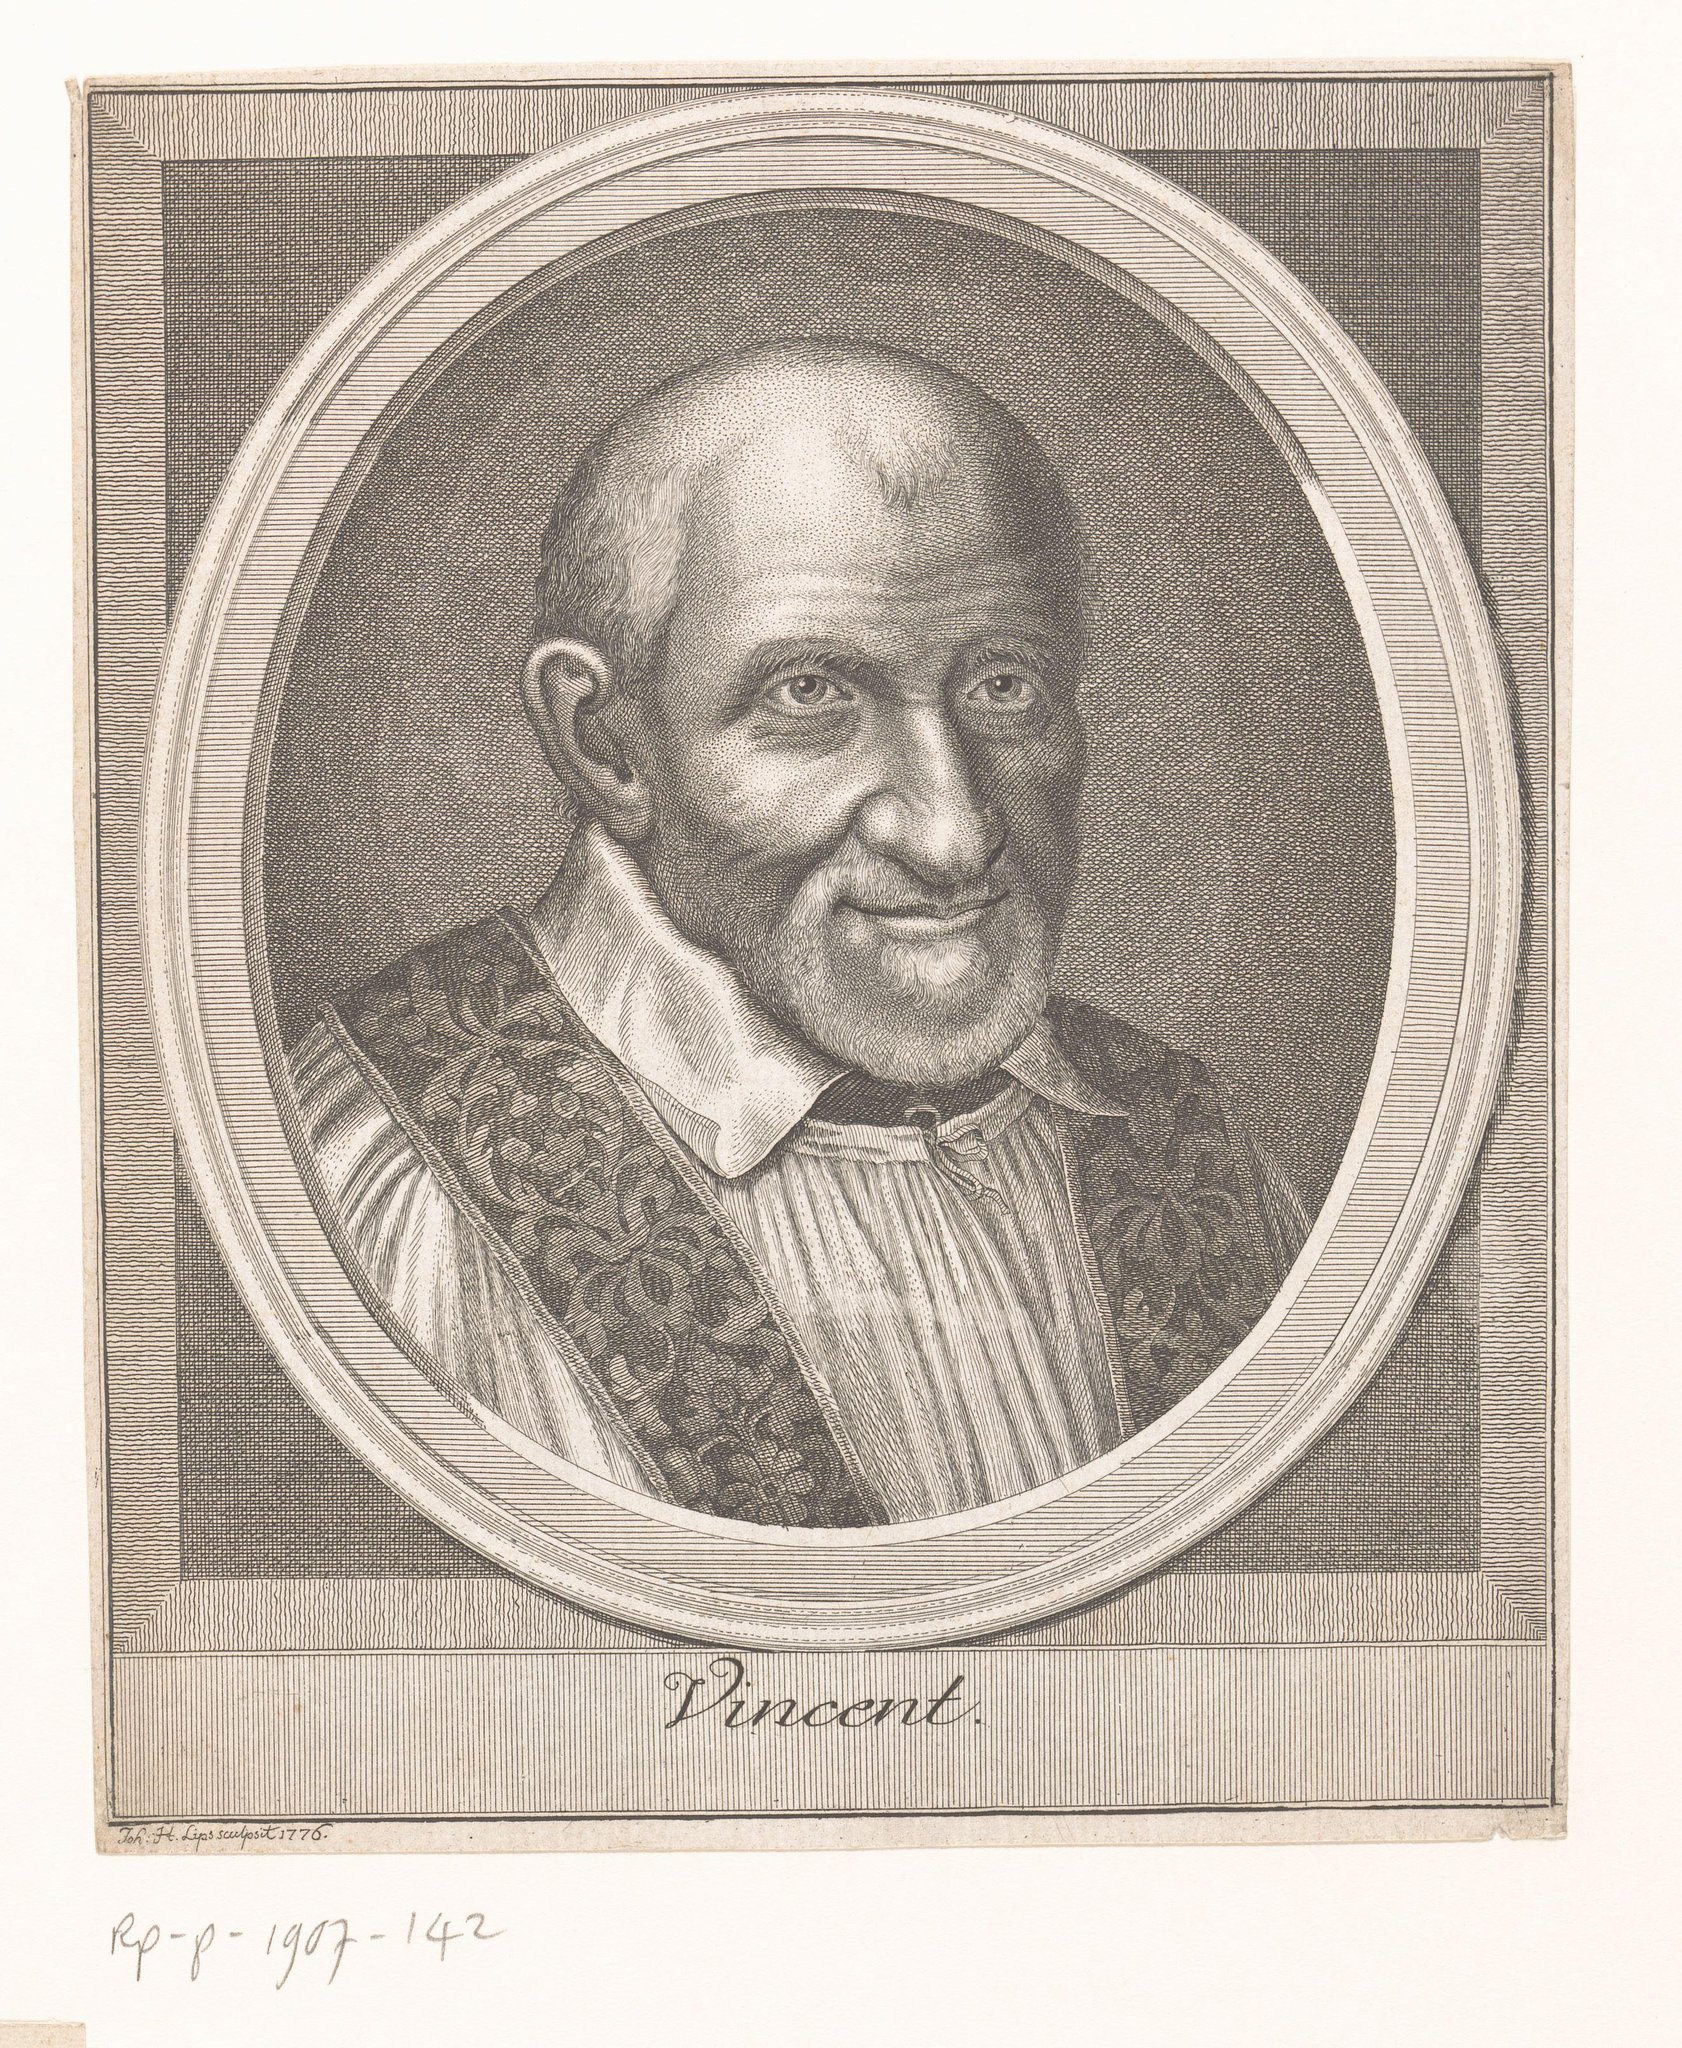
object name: print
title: Portret van Vincent de Paul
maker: johann heinrich lips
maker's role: draughtsman, painter, print maker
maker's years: 1758-1817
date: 1776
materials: paper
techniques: engraving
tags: priest, theologian, historical persons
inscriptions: collector's mark: Lugt 2228